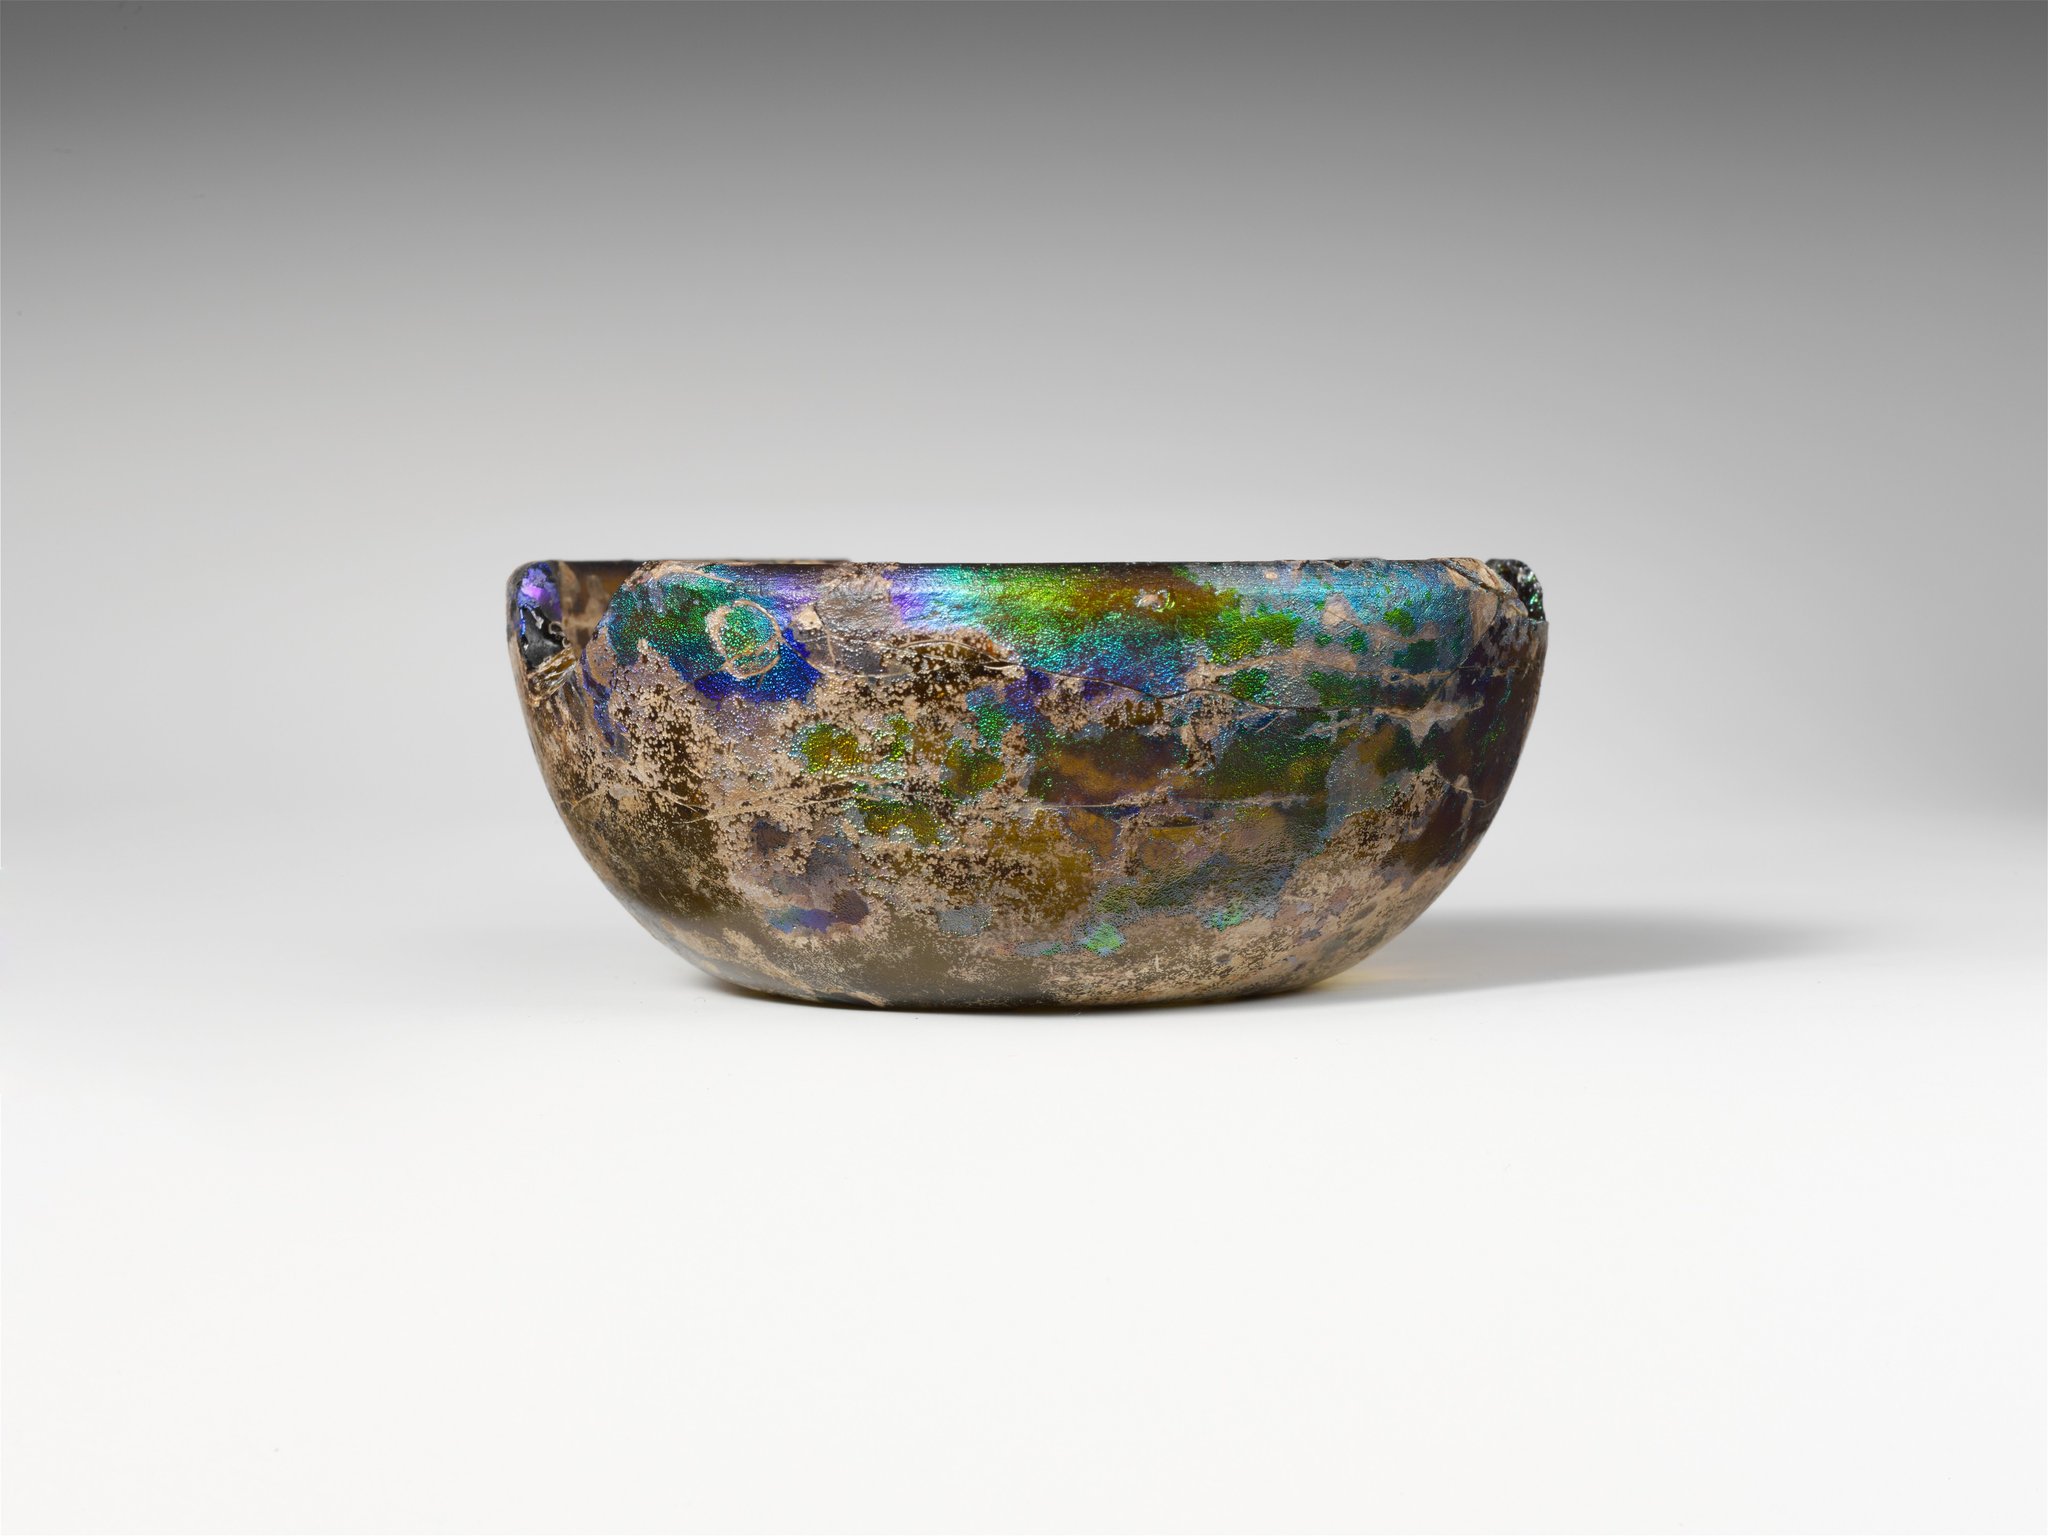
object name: bowl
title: Glass bowl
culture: greek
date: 167-68 BCE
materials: glass